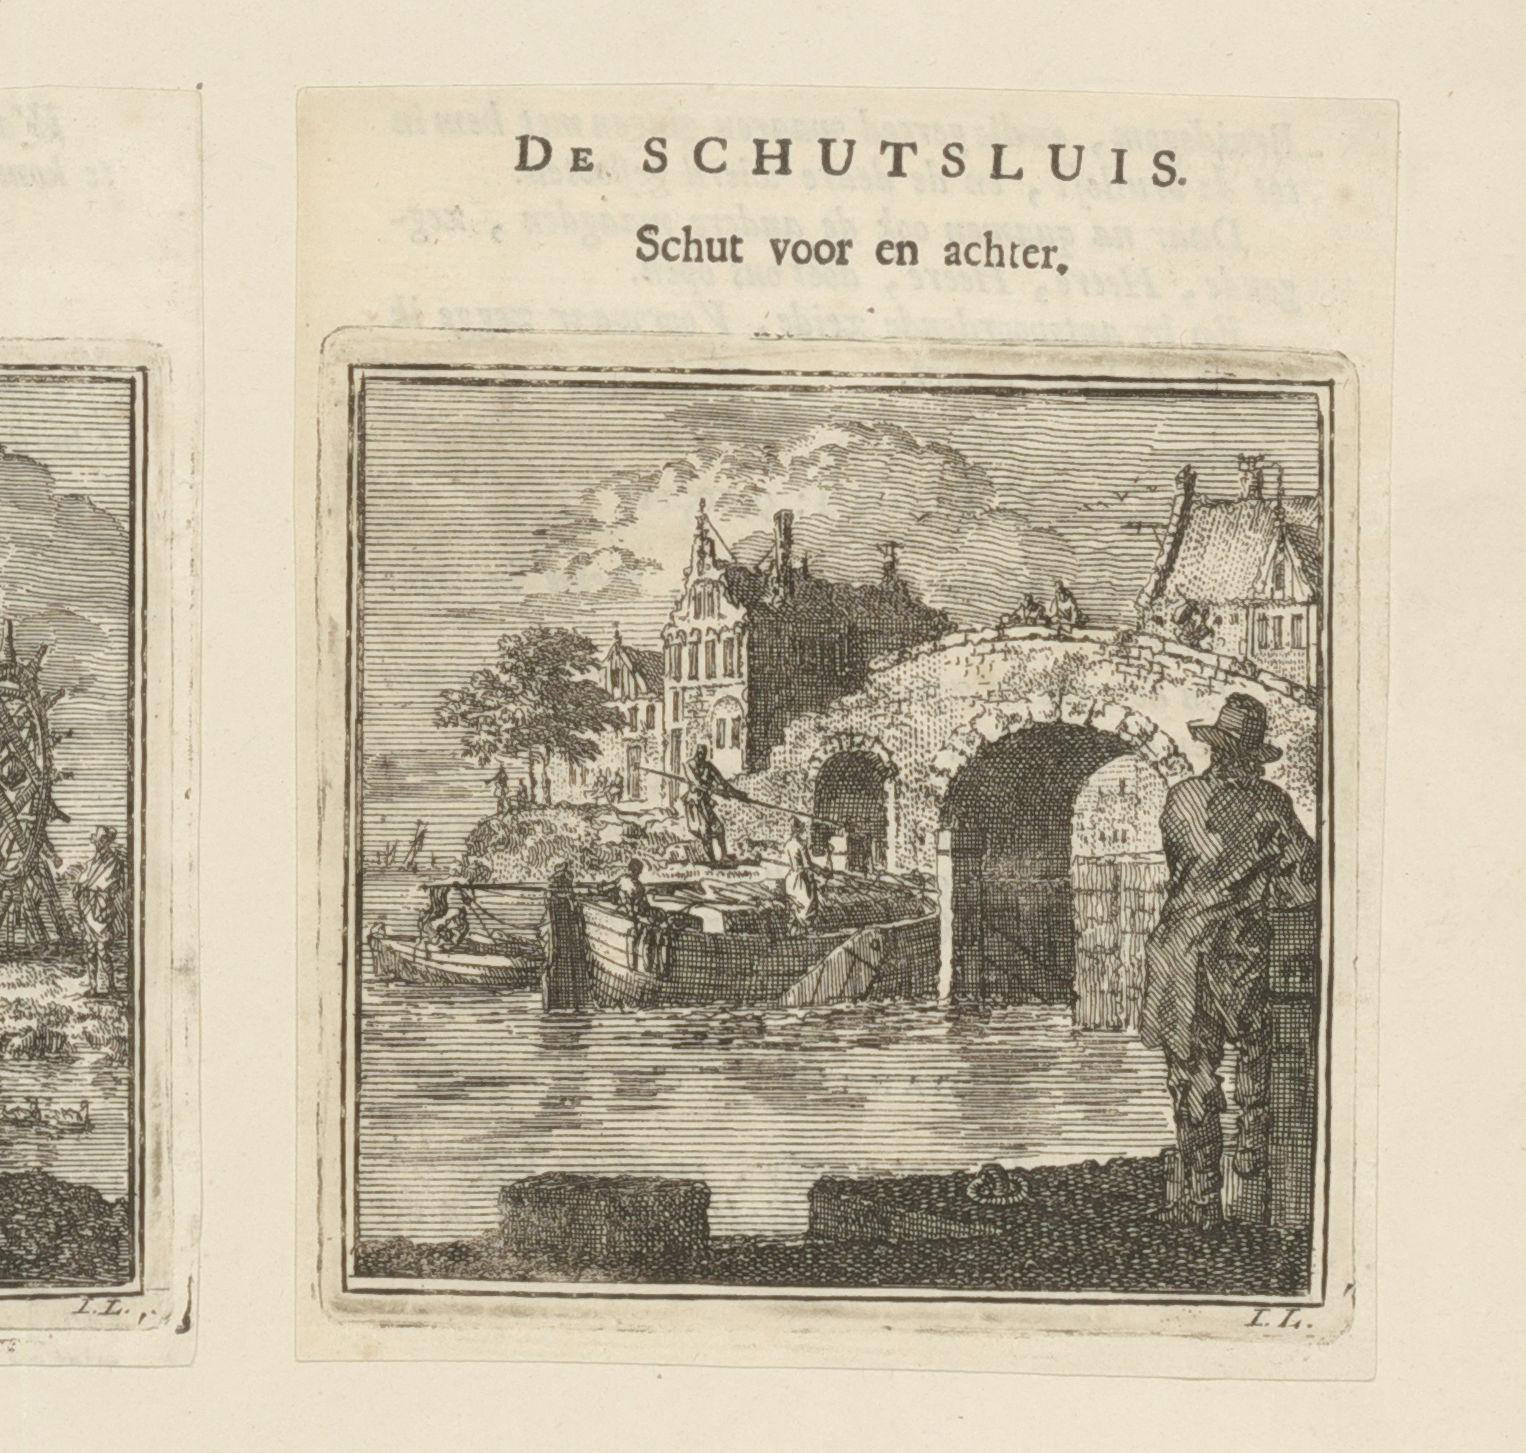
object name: print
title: De Schutsluis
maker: jan luyken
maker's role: draughtsman, print maker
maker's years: 1649-1712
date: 1711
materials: paper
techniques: etching, letterpress printing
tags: sluice, weir, ships (in general)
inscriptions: stamp, collector's mark: Lugt 1641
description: Prent uit: Luyken, Jan. De Bykorf des Gemoeds. Amsterdam: Pieter Arentsz. II (wed.) en Cornelis van der Sys, 1711.